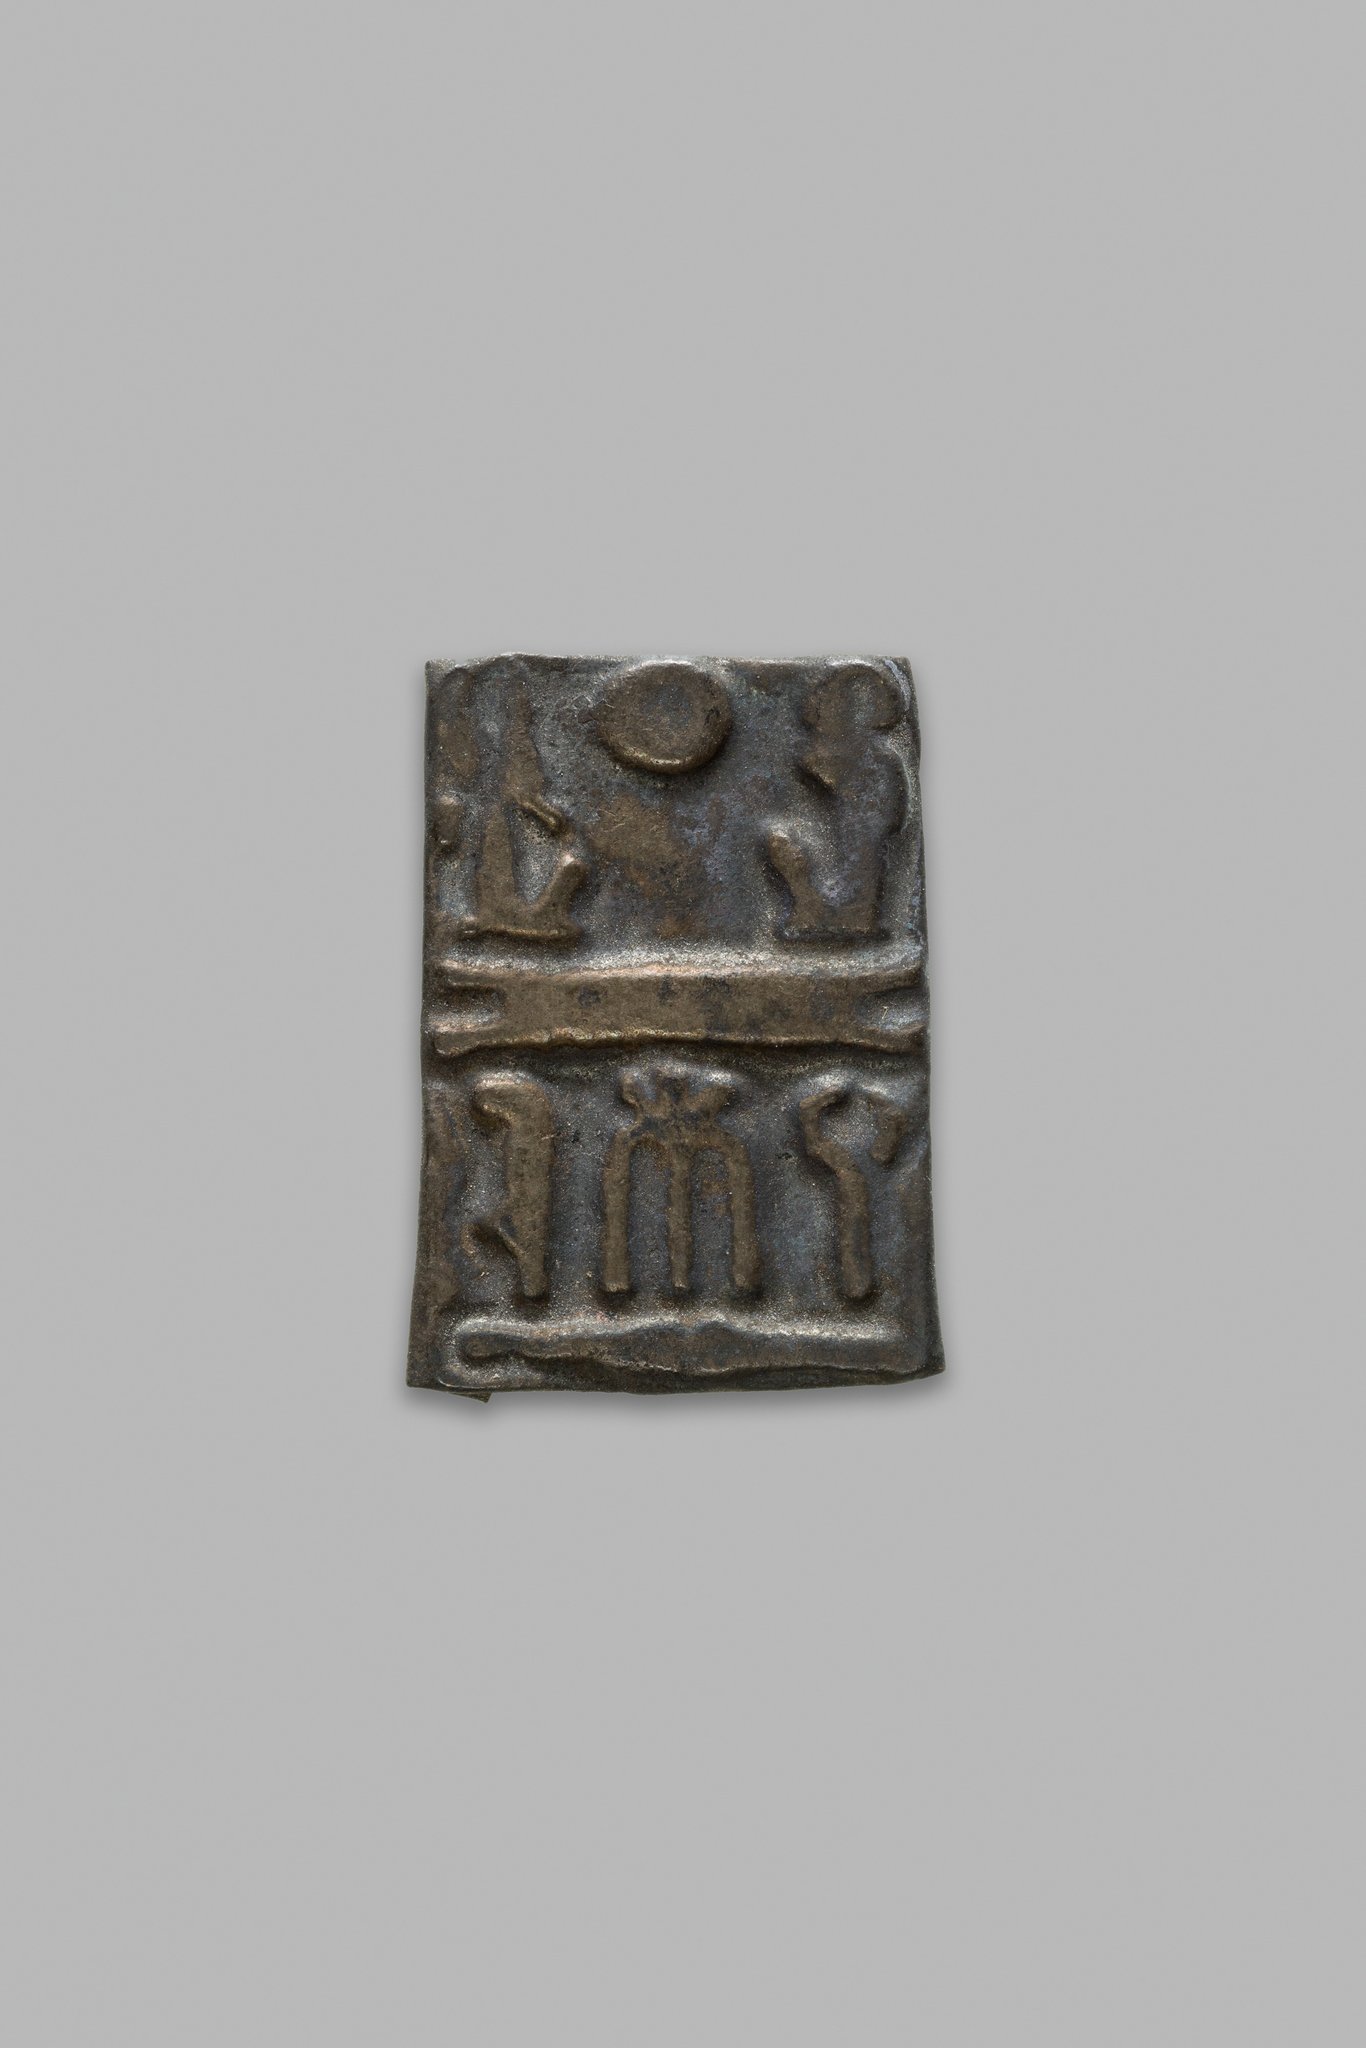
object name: foundation deposit, plaque, rectangular, ramesses iv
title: Inscribed Rectangular Plaque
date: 1153-1147 BCE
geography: egypt